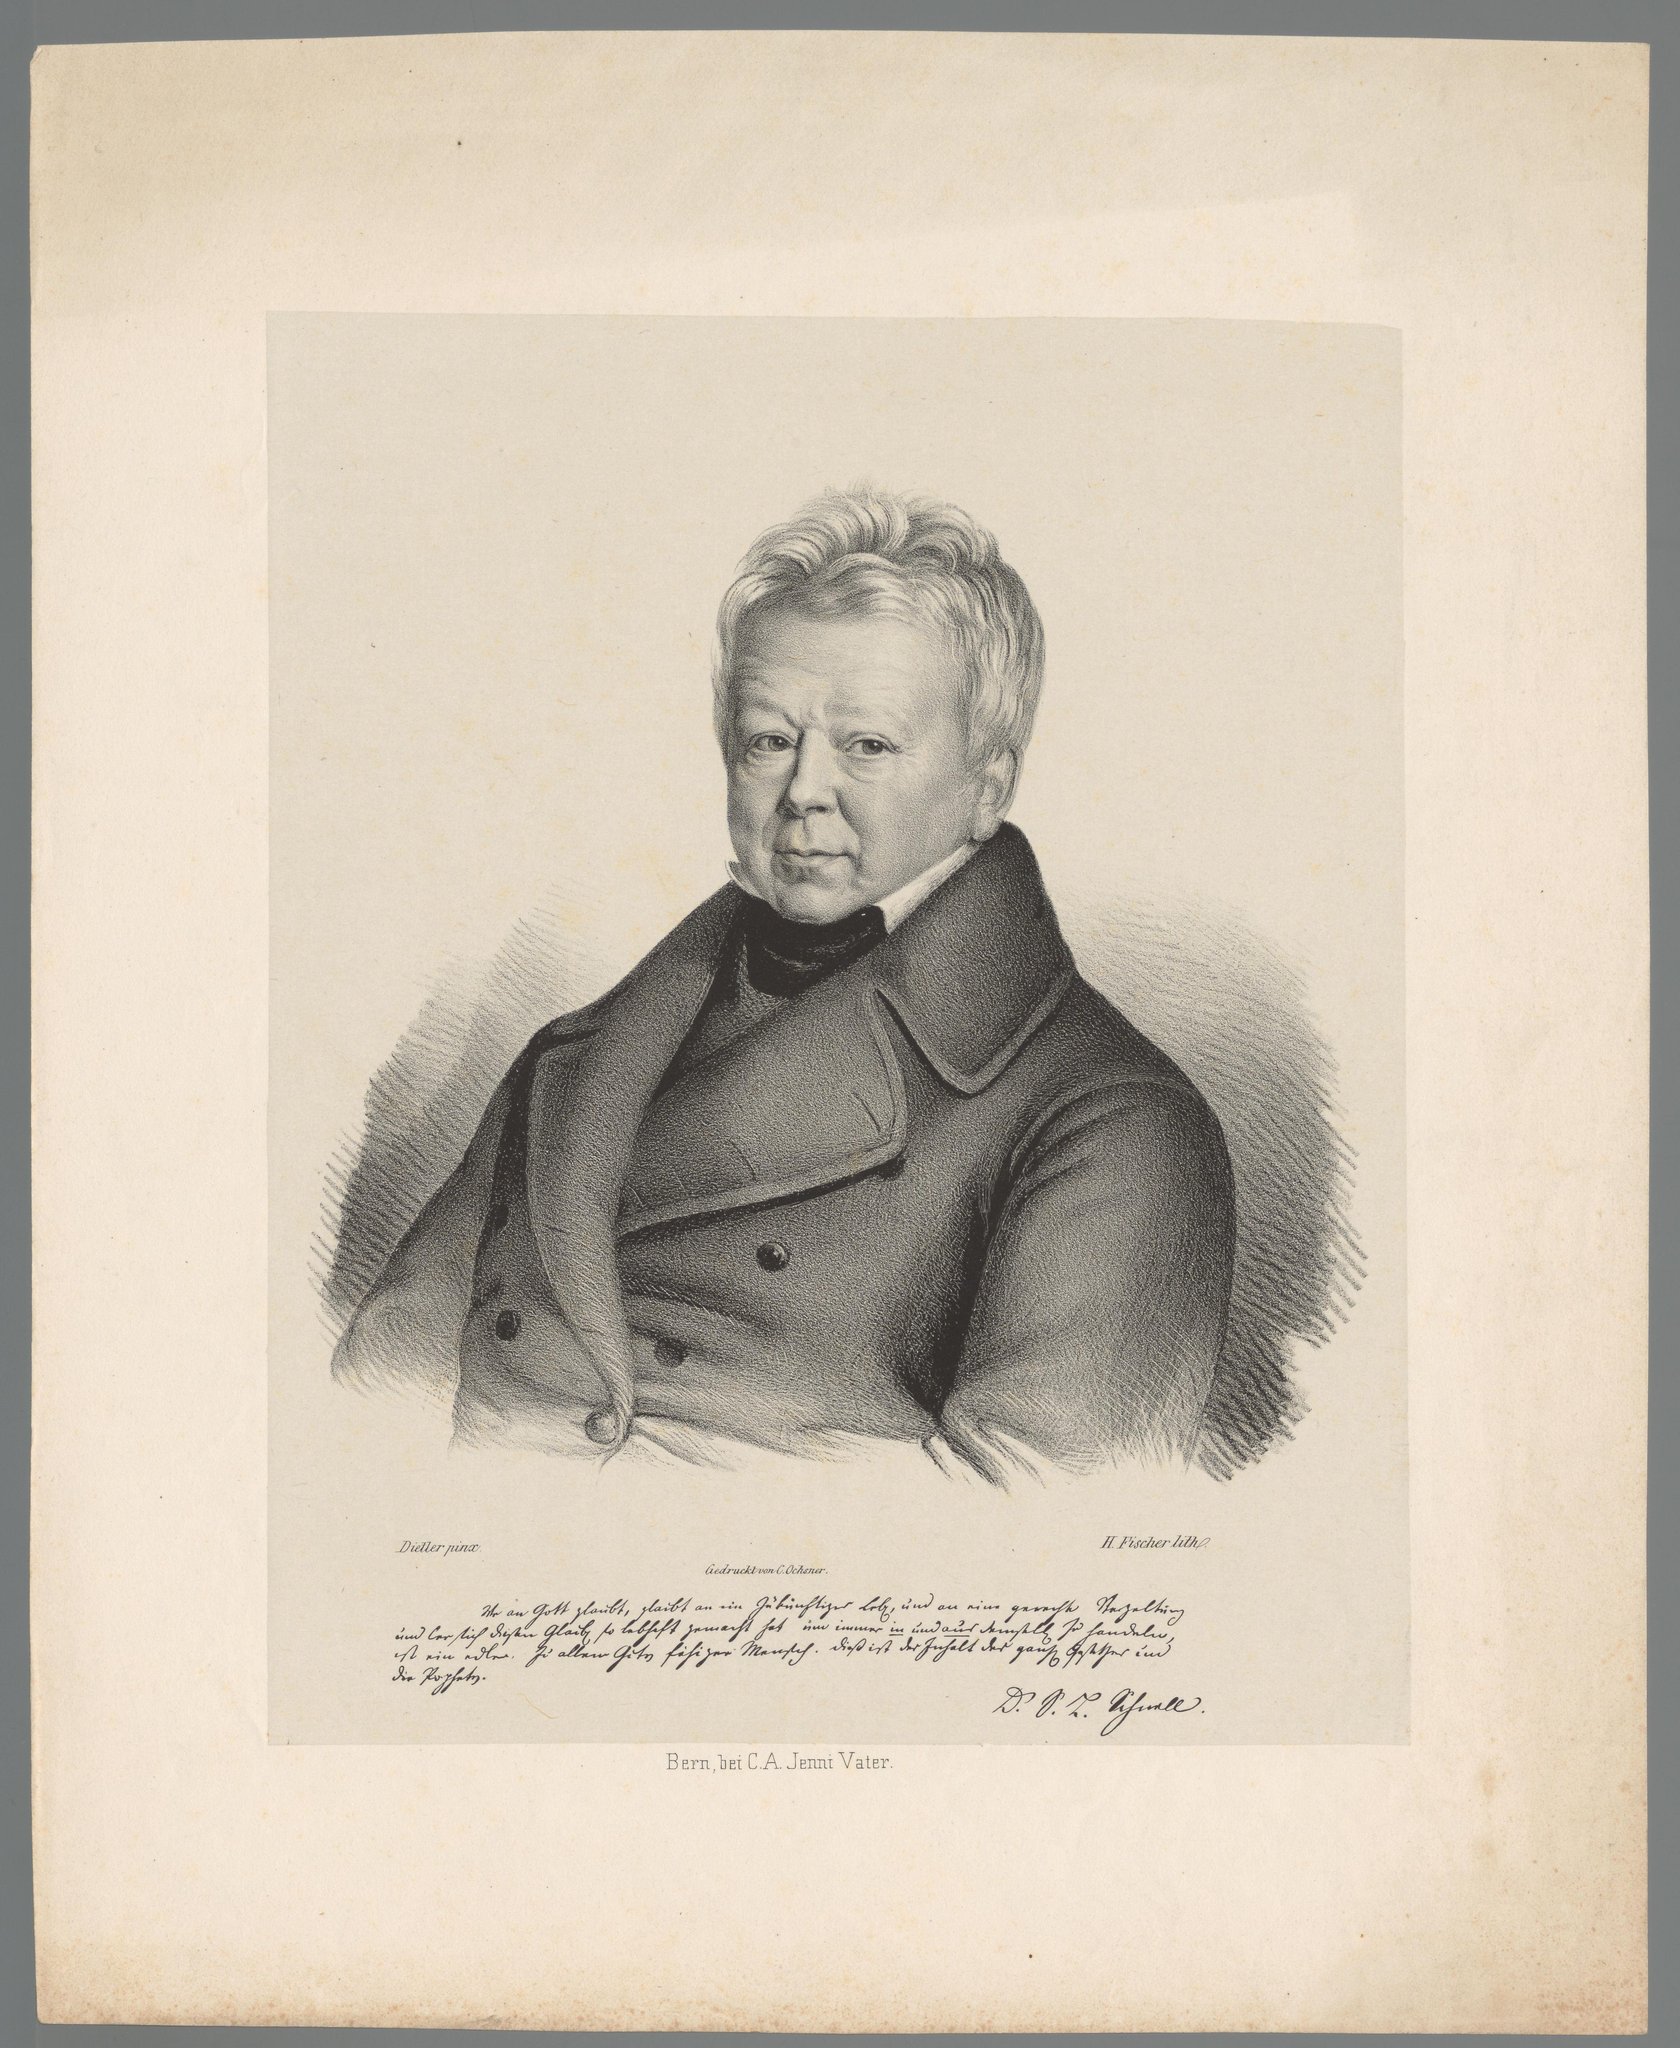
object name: print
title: Portret van een onbekende man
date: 1830-1860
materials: paper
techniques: lithograph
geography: bern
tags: historical persons not known by name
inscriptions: collector's mark: Lugt 2228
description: Portret van een verder onbekende militair, met handtekening in facsimile waarin mogelijk de naam Schnell te lezen is.